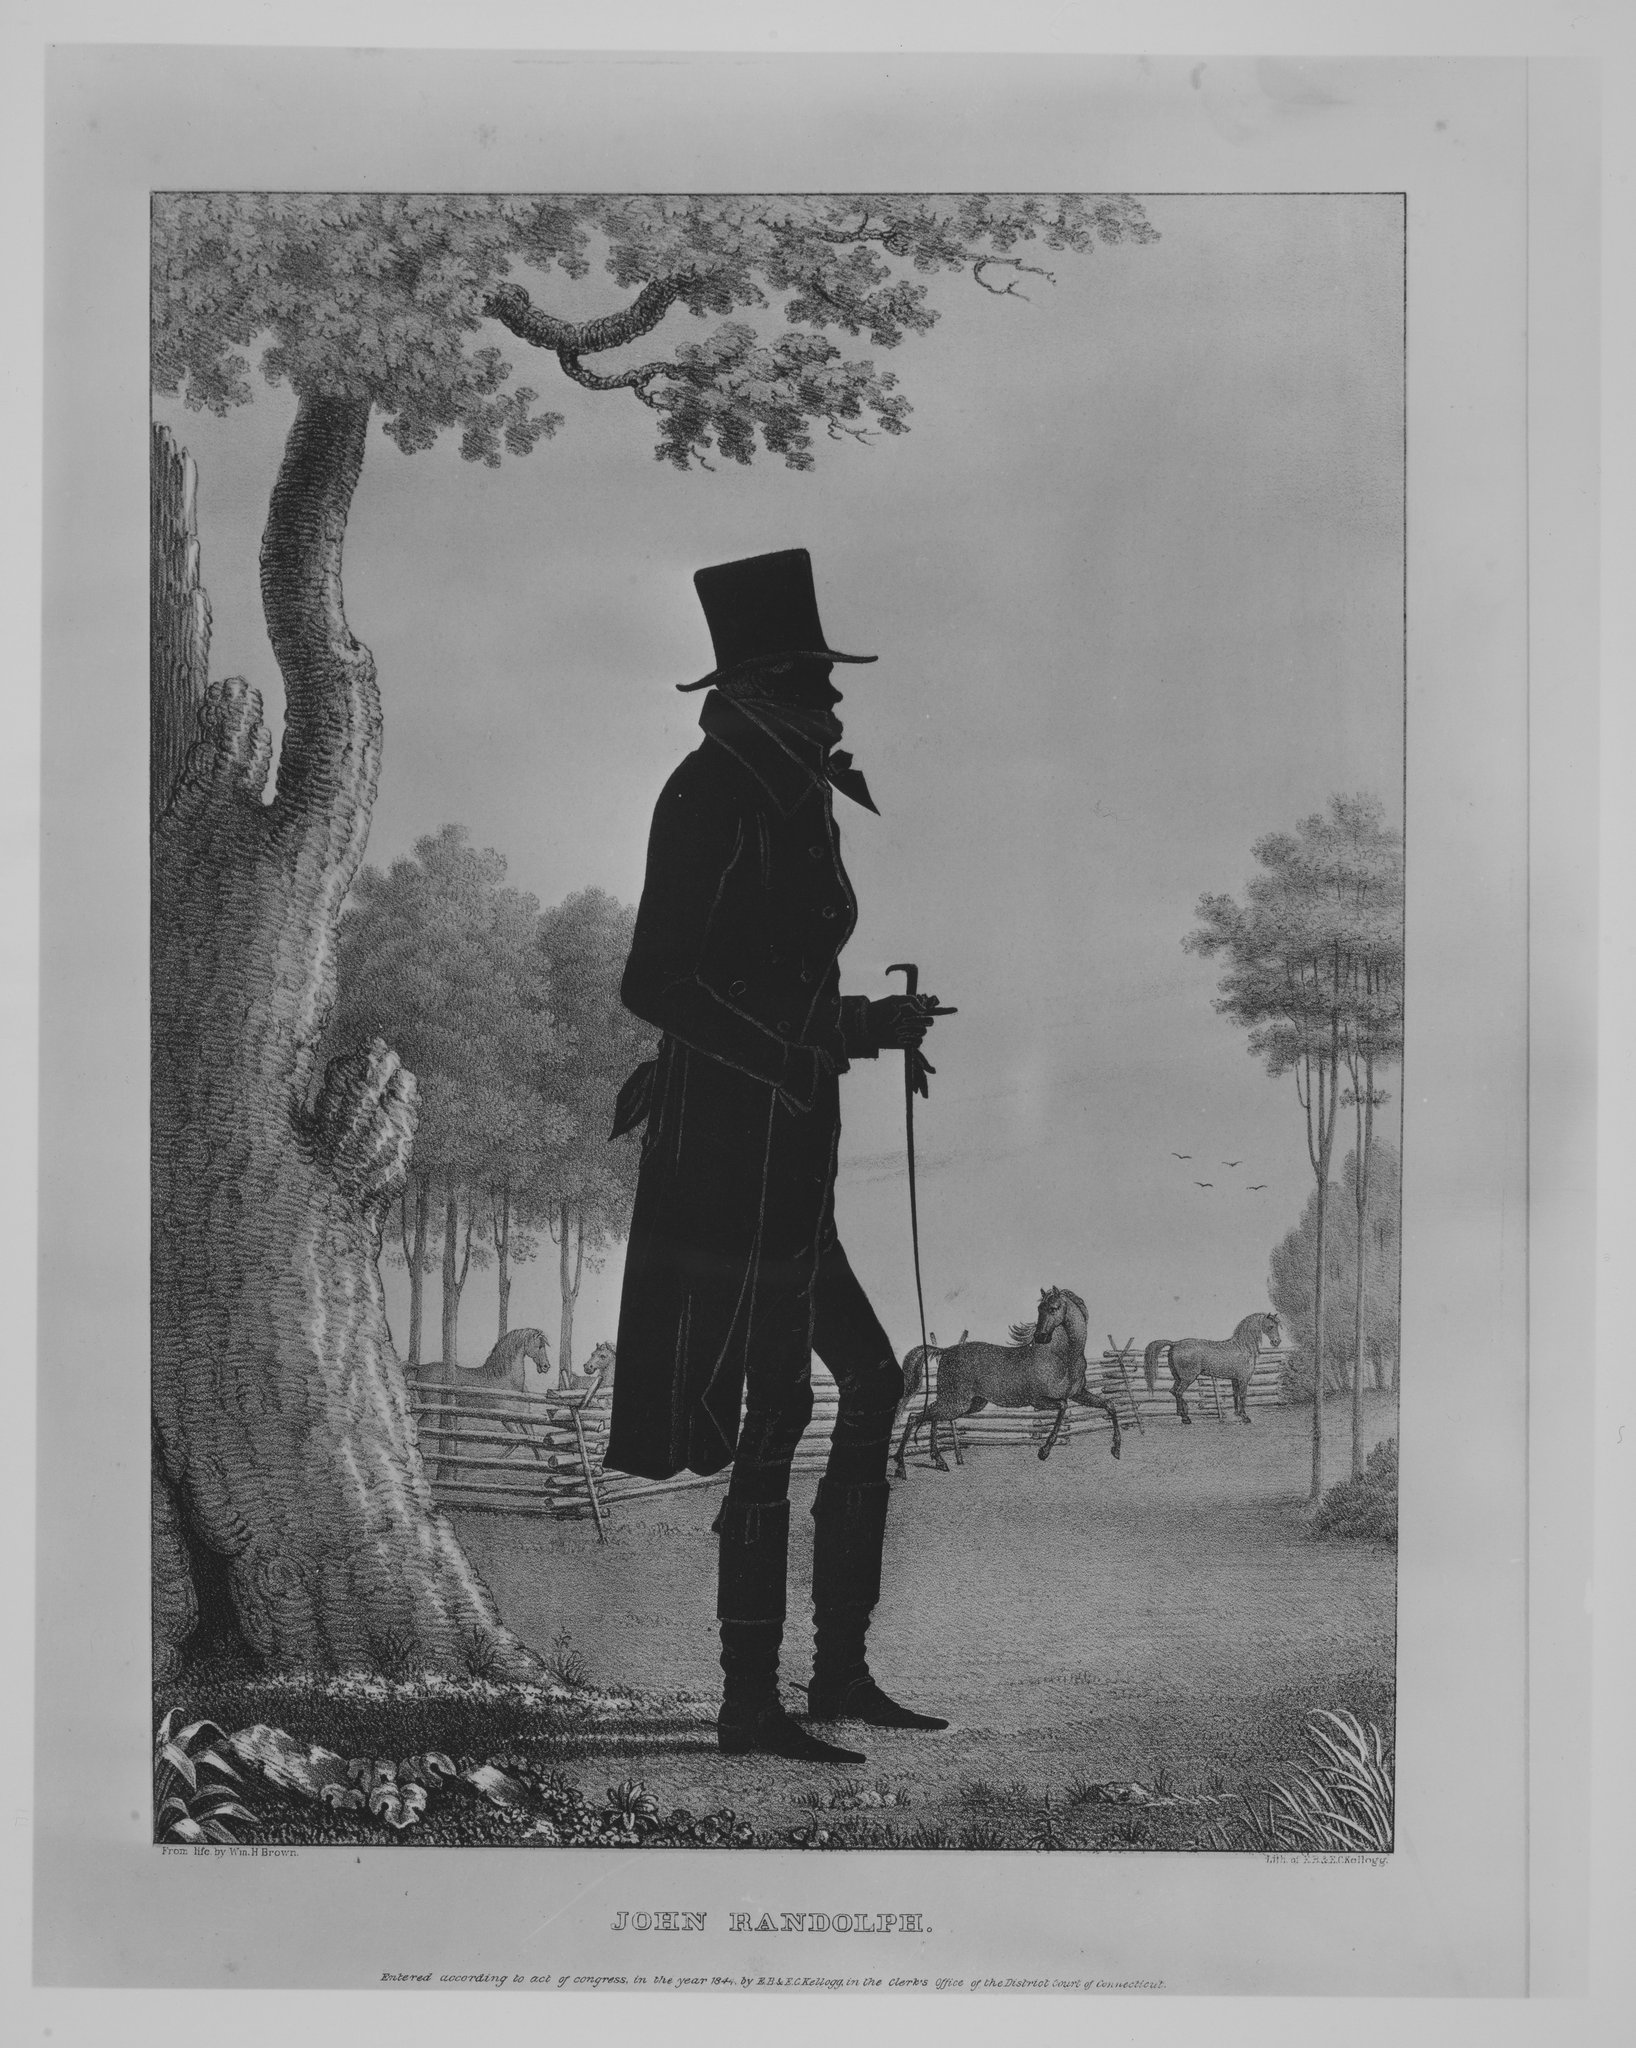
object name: print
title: Silhouette Portrait of John Randolph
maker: william henry brown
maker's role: artist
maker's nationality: american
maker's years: 1808-1883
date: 1844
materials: stone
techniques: lithograph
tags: men,horses